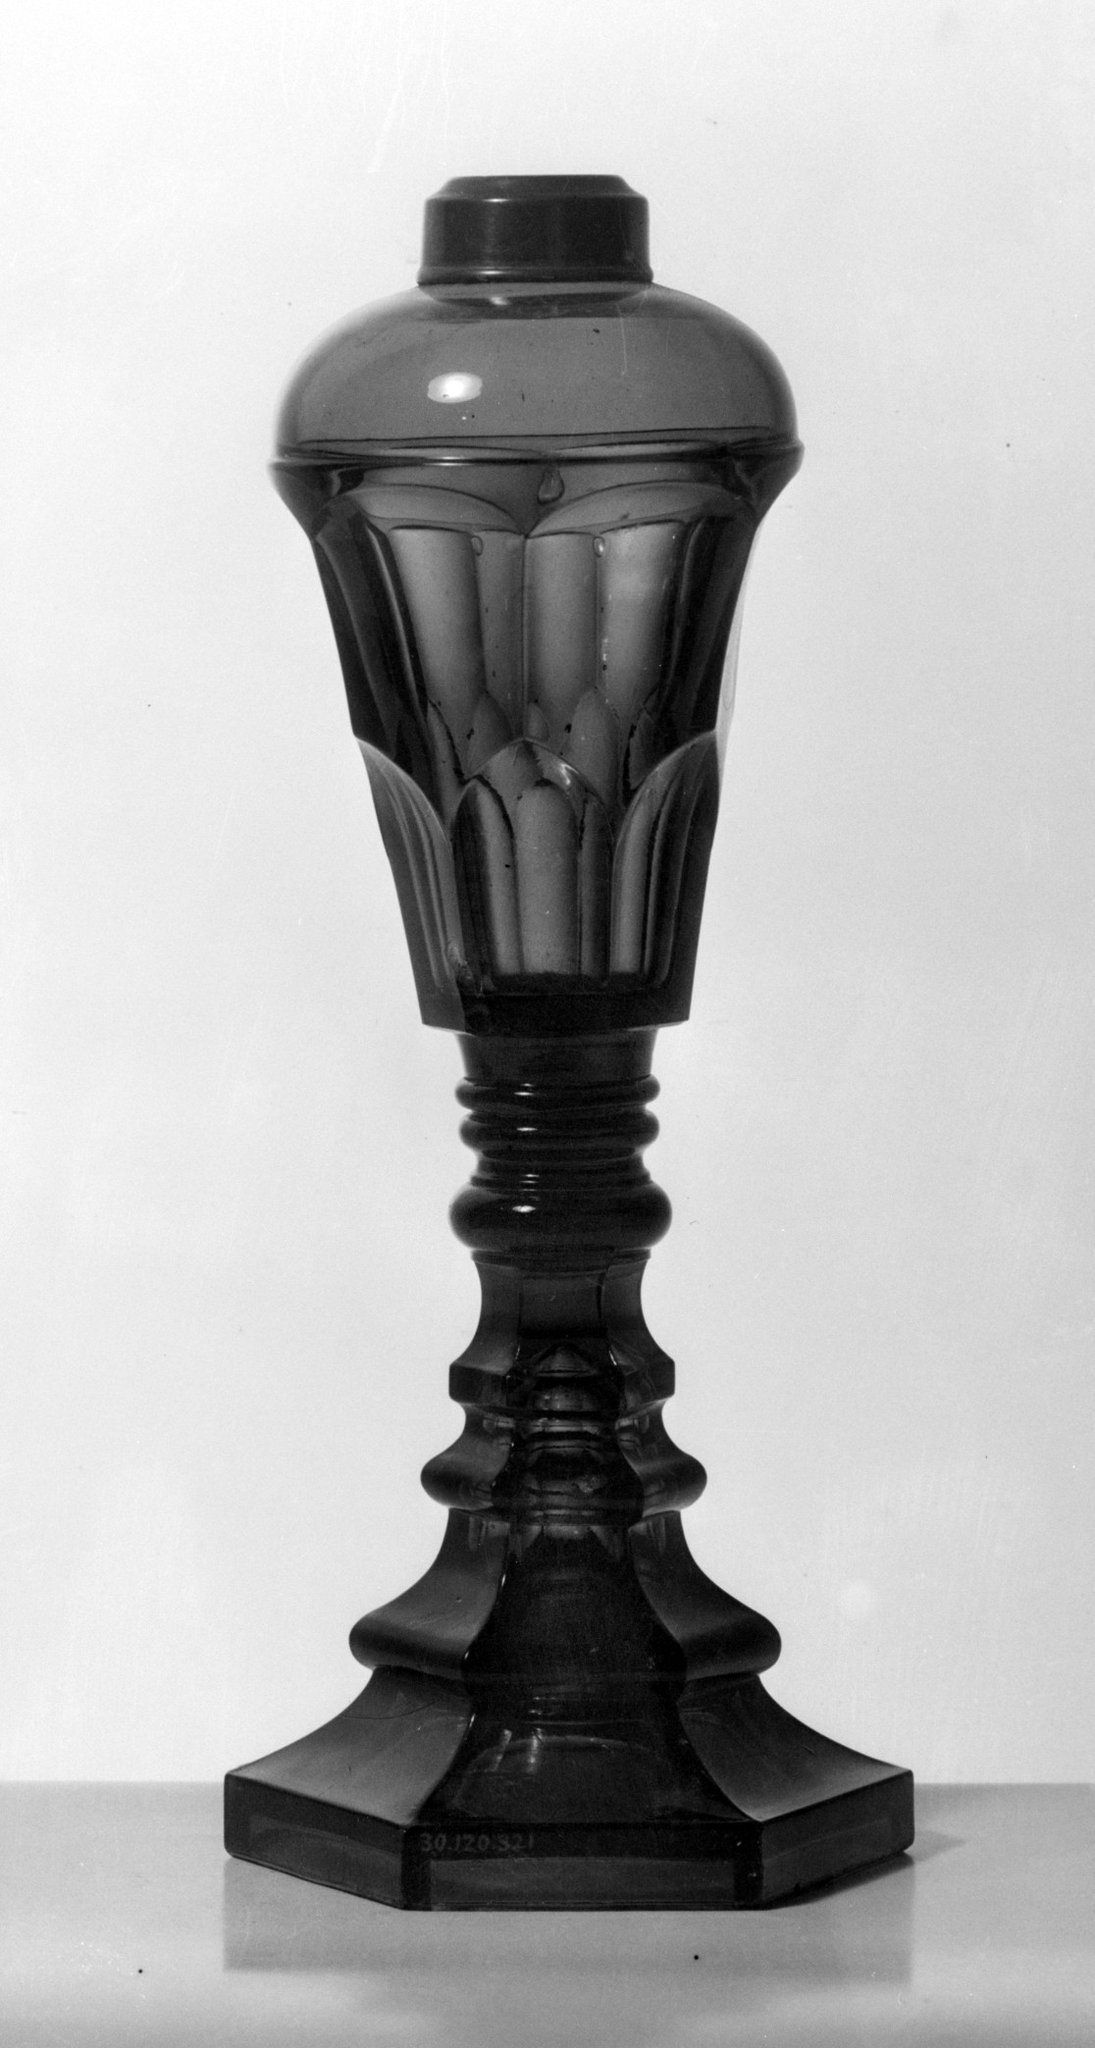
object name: lamp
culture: american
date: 1850-1875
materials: glass, metal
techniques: glassblowing, molding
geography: united states